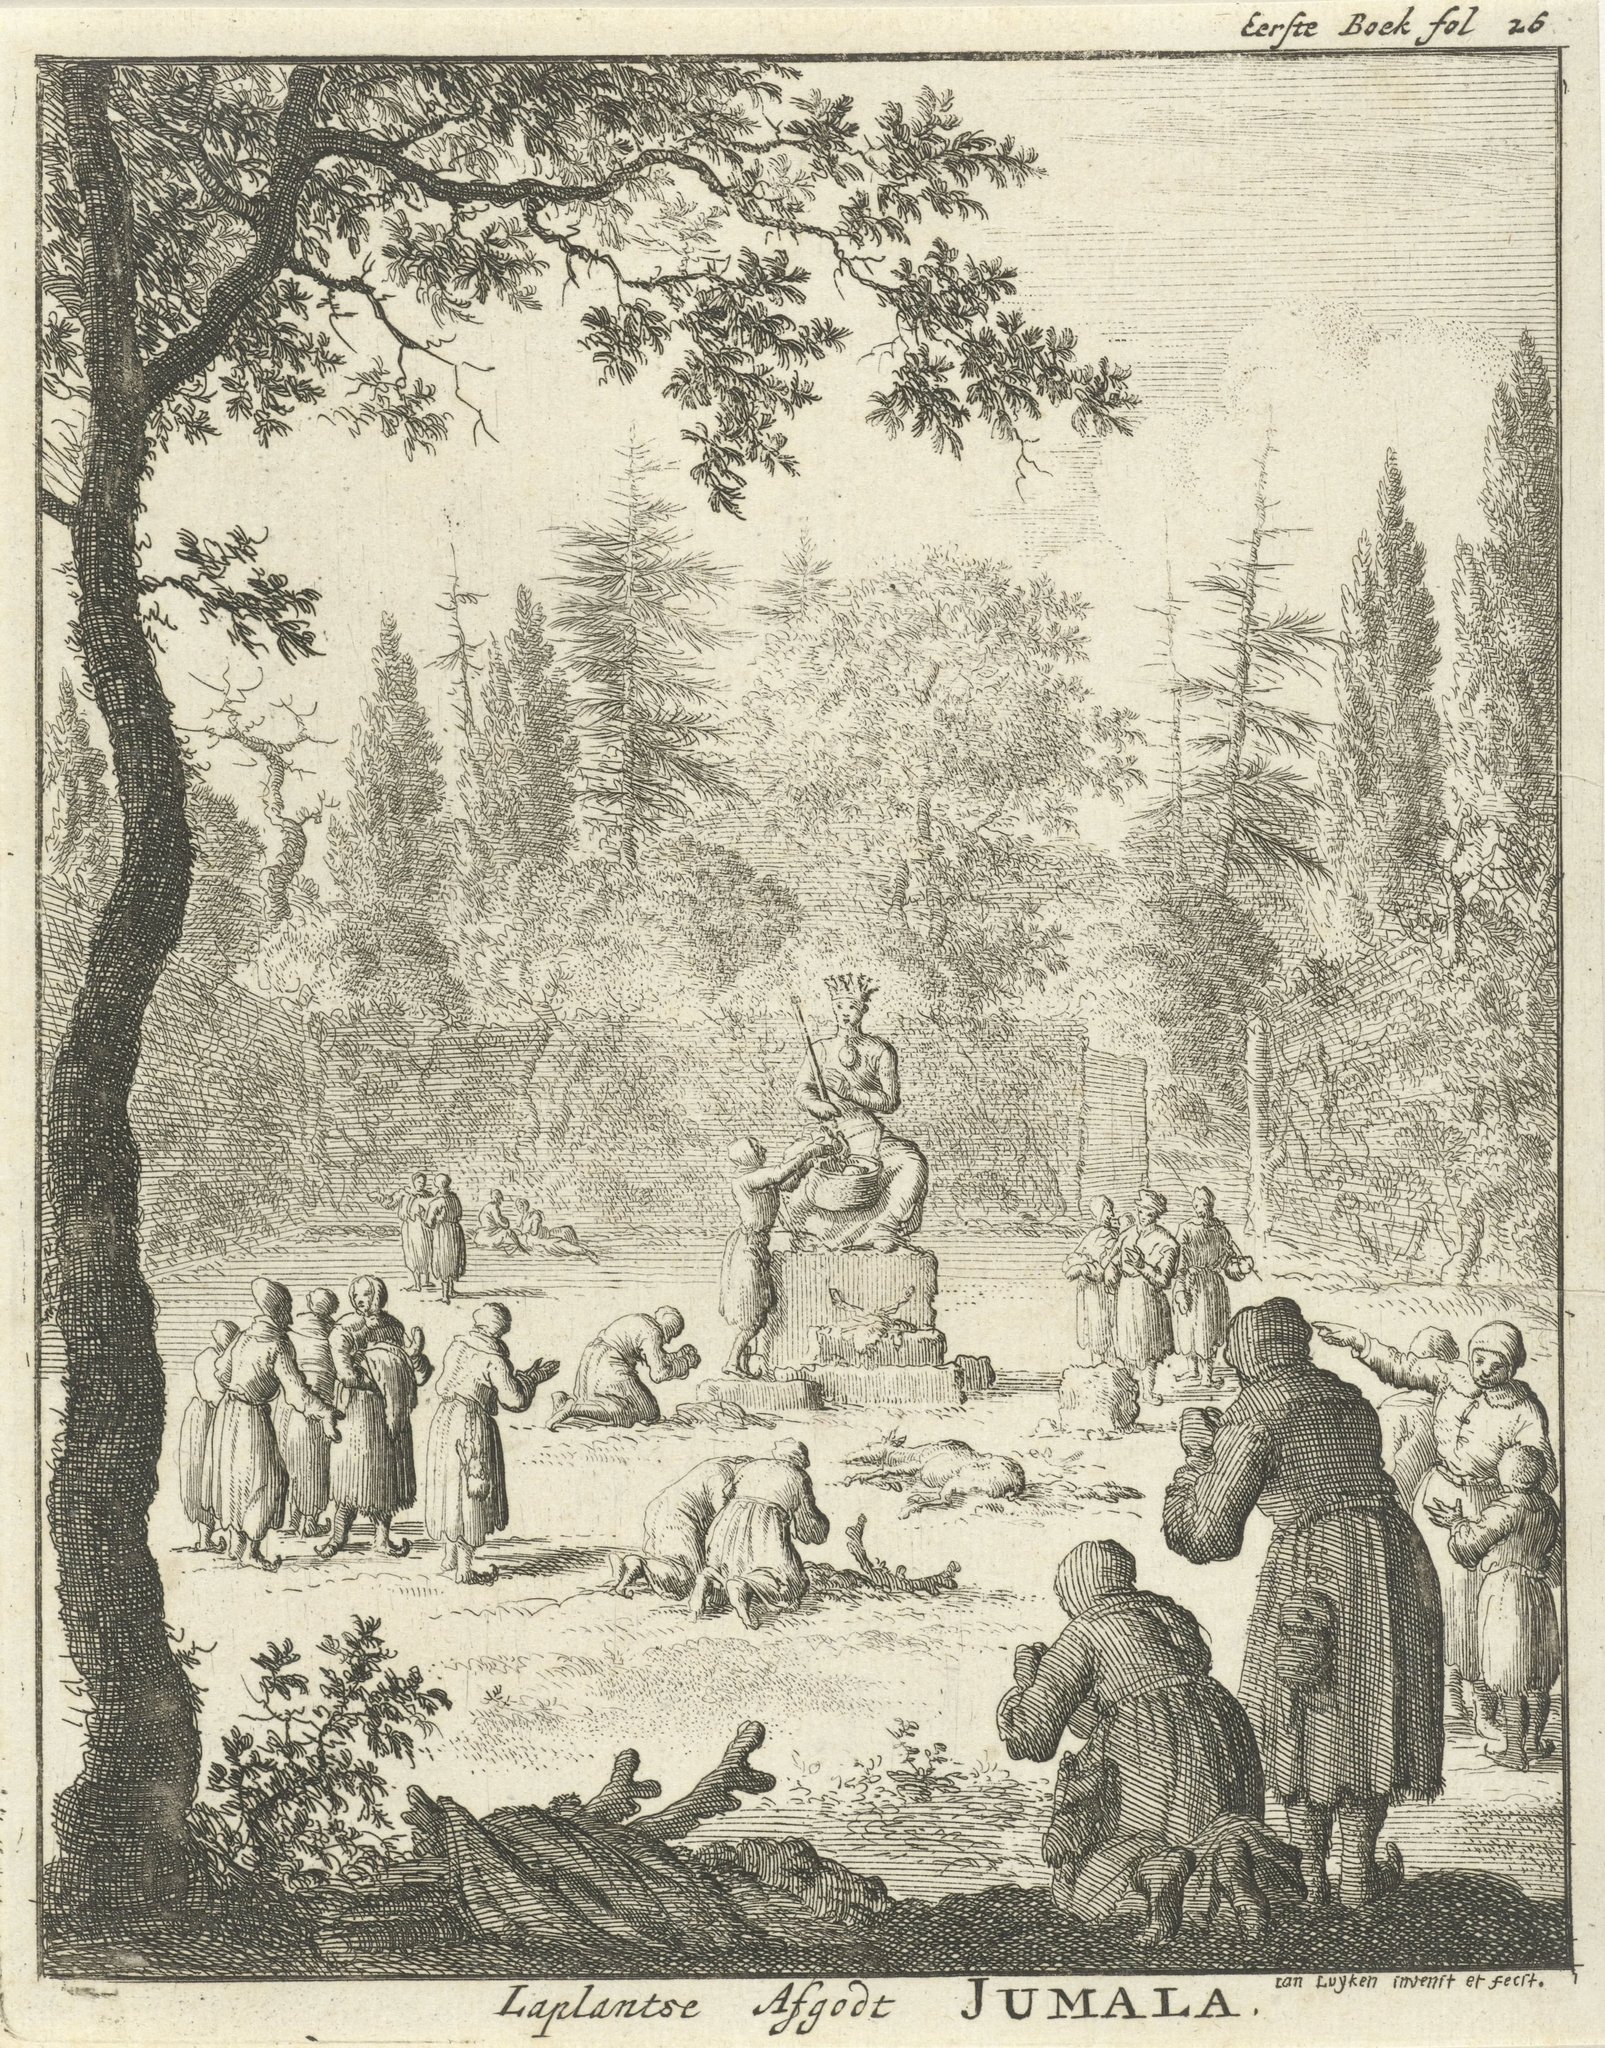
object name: print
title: Sami vereren de oppergod Jumala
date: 1682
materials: paper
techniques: etching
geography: amsterdam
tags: europeans: sami, worship and devotion ~ non-christian religions, sápmi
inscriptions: collector's mark: Lugt 2228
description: Illustratie opgenomen in: Scheffer, Johannes. Waarachtige en aen-merkens-waardige historie van Lapland. Amsterdam: Jan Claesz ten Hoorn, 1682.